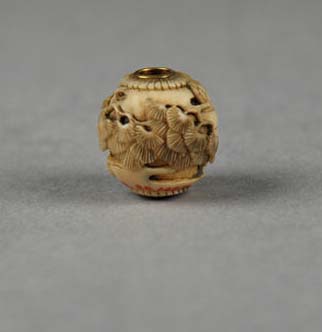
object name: bead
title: Carved Bead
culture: japanese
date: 1801-1900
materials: ivory